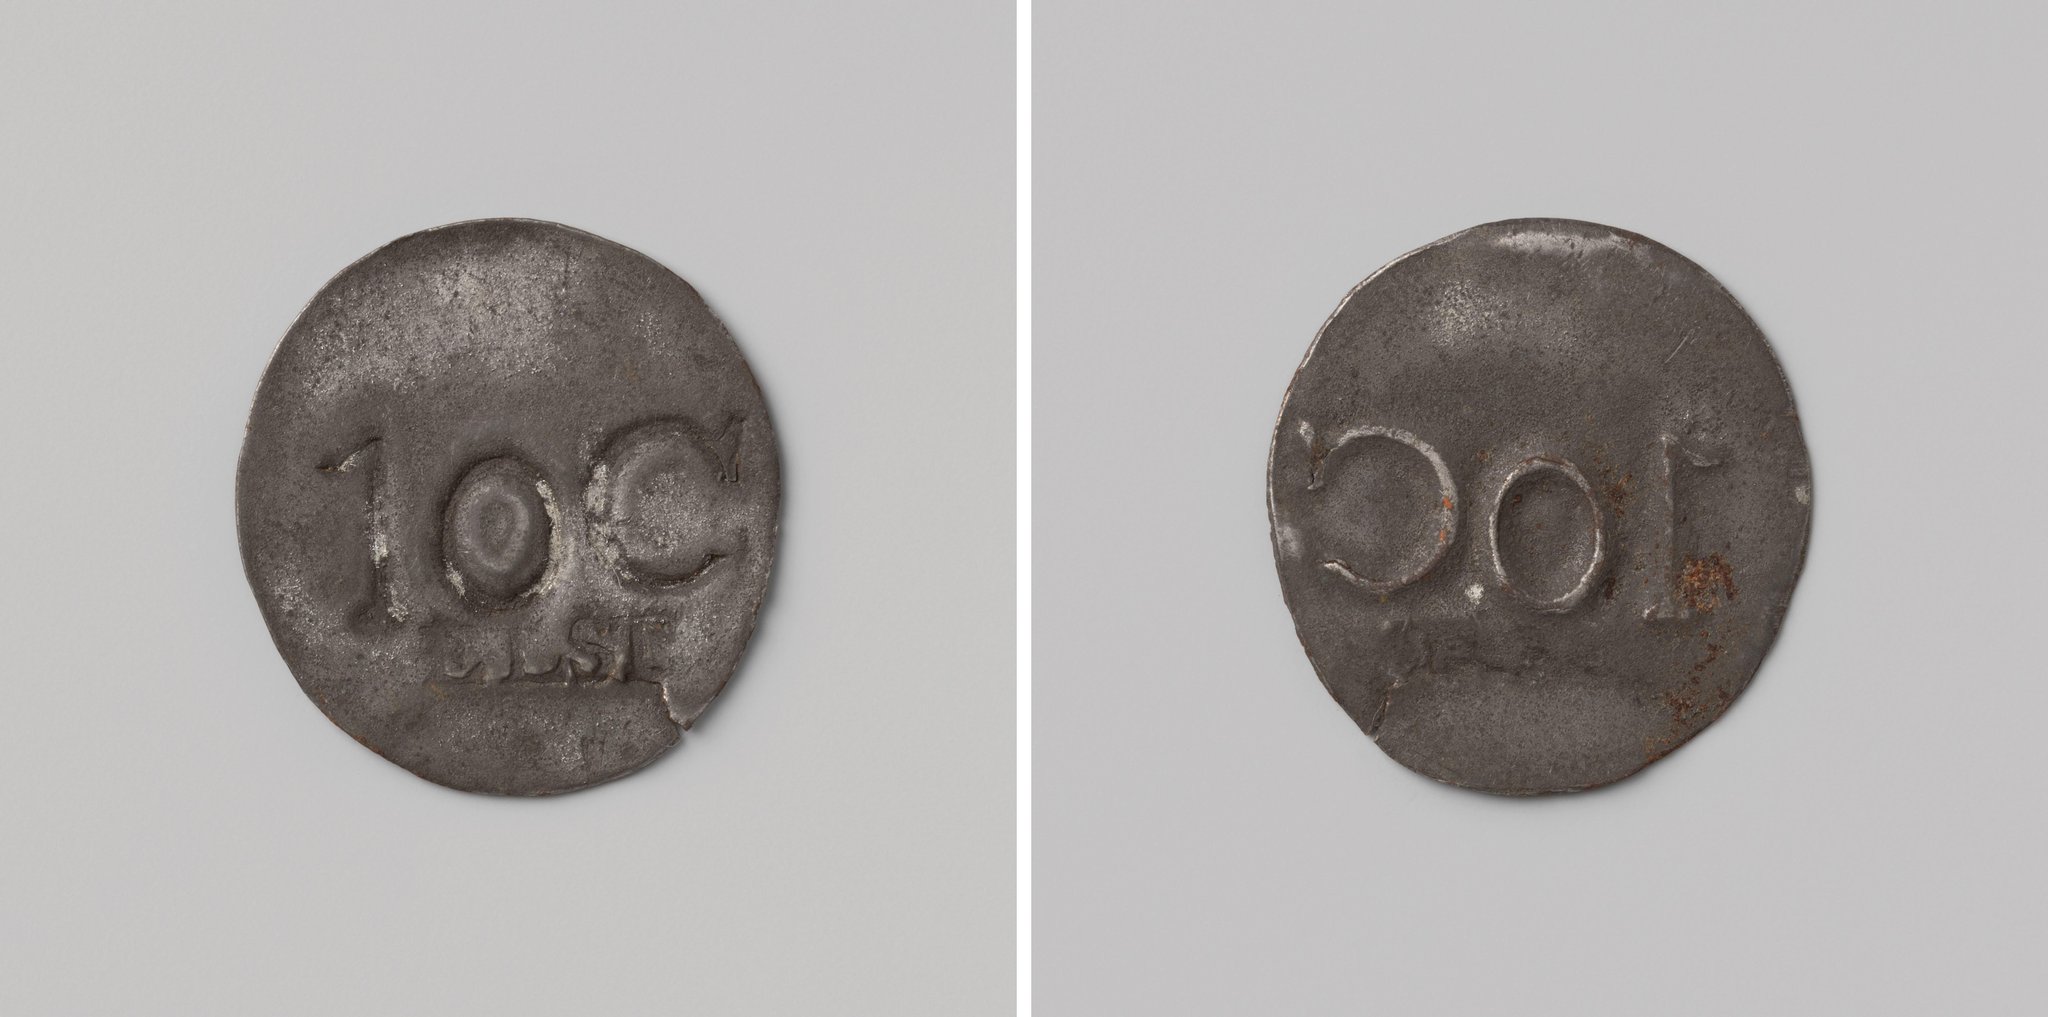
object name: monetary token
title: Gevangenisgeld van tien cent uit Aalst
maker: d.a. schretlen junior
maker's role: blikslager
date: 1827-1830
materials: silver, metal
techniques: silvering, striking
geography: leiden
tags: elst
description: eenzijdige betaalpenning. Voorzijde: waardeaanduiding boven klop: met opschrift 'ELST'. Keerzijde: blanco